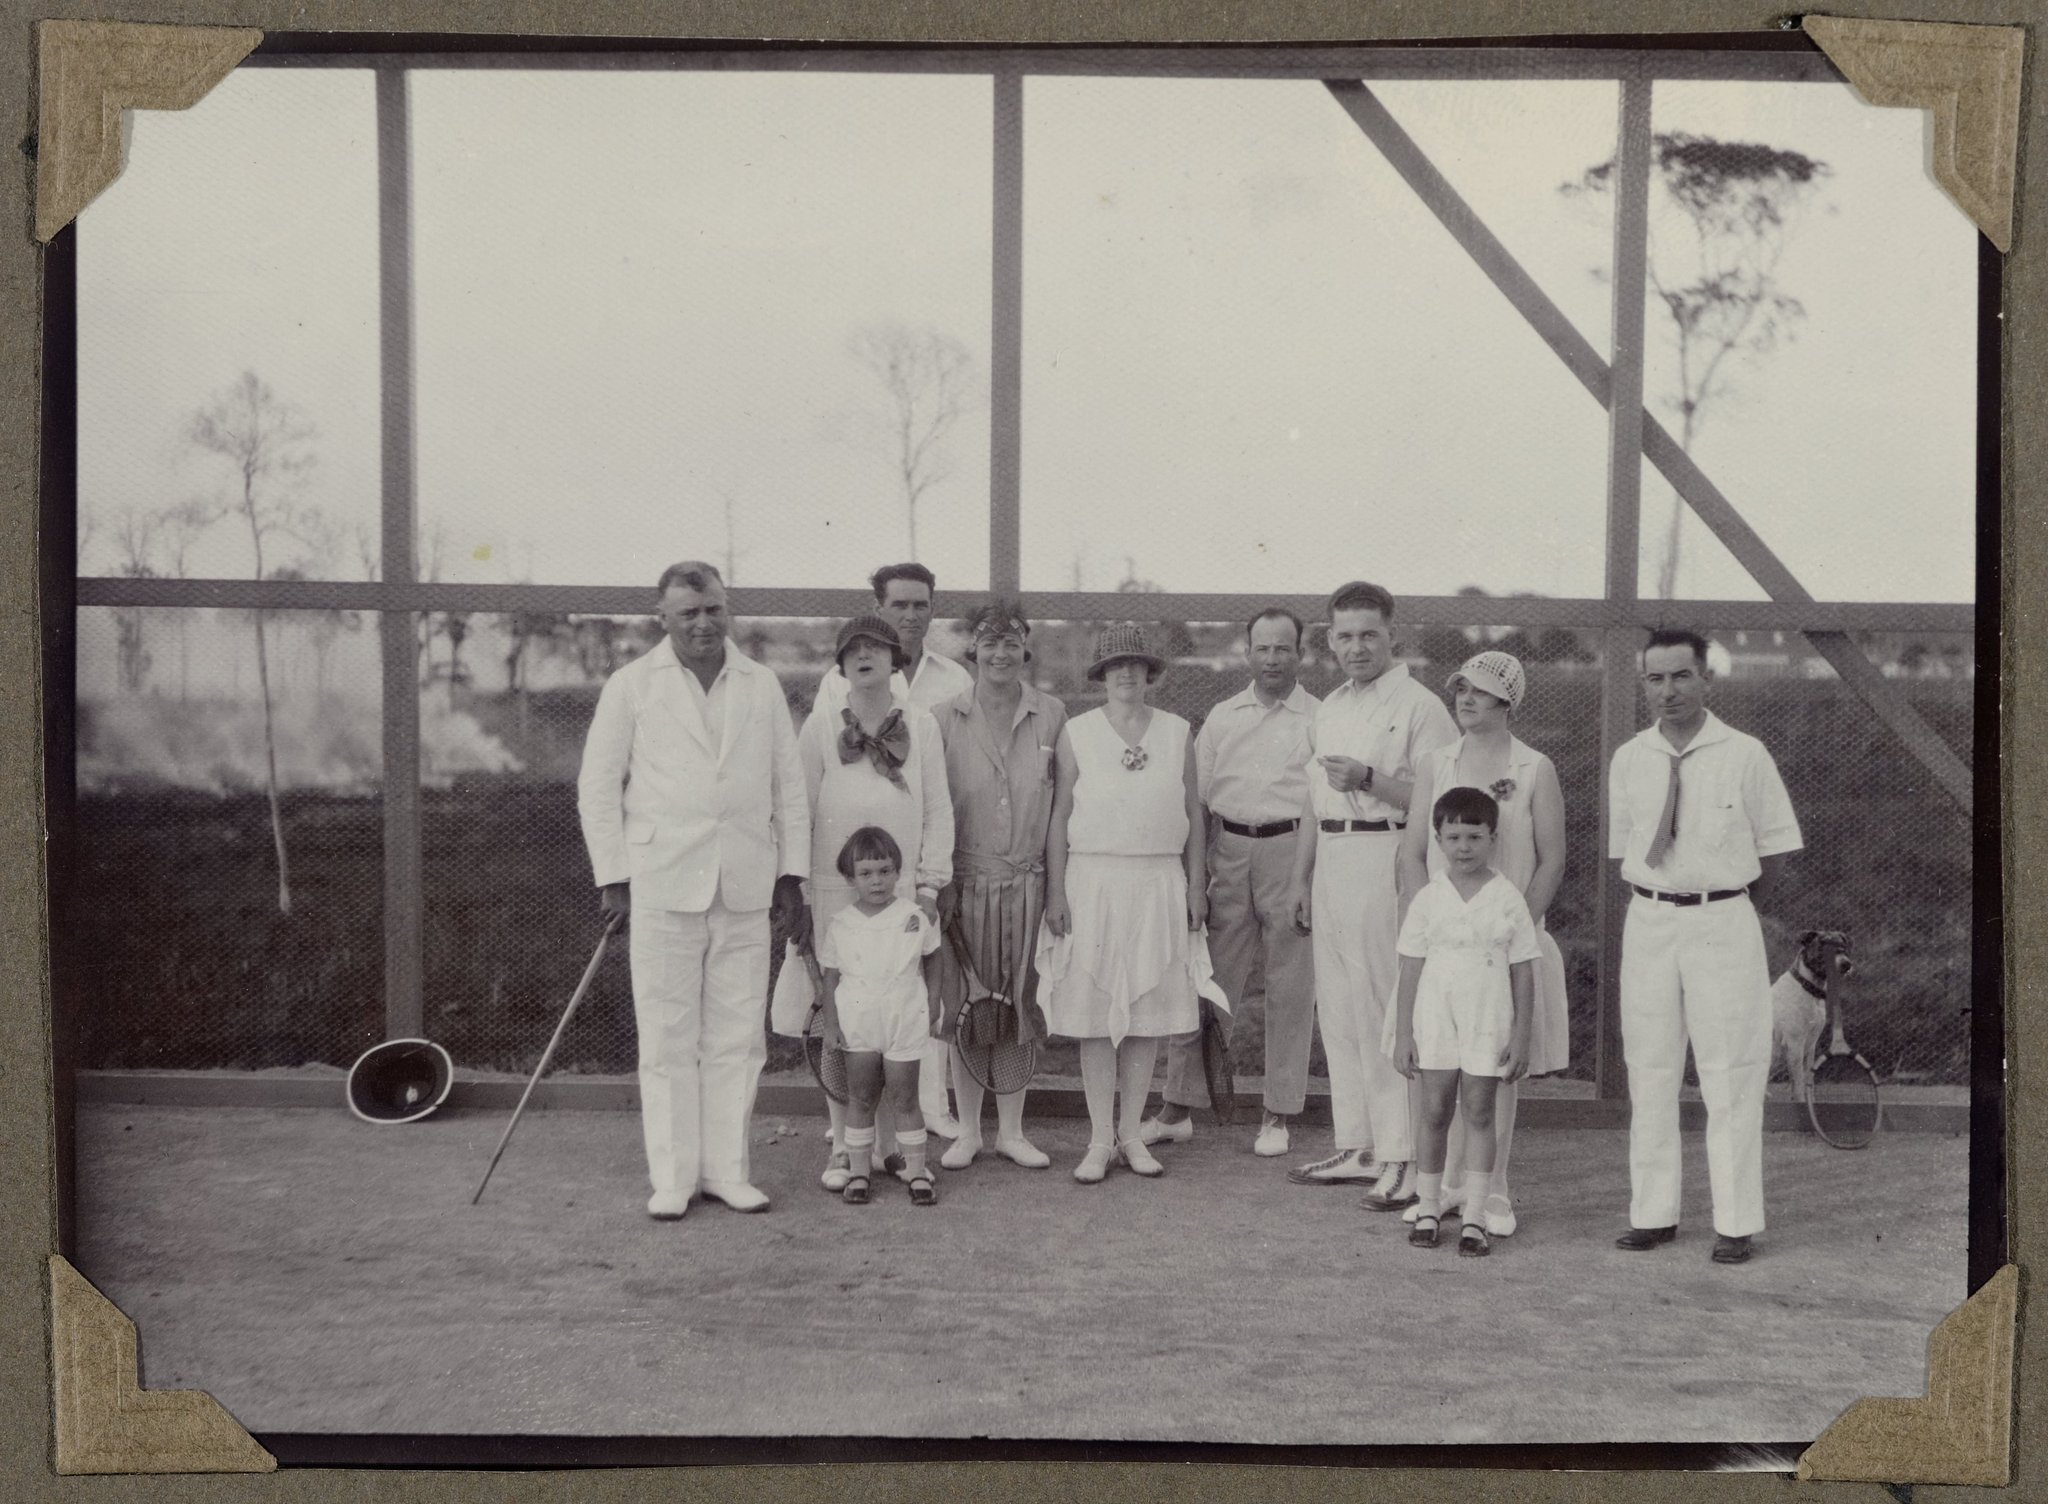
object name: photograph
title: Groepsfoto op de tennisclub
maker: Anonymous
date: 1925-1927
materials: photographic support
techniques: photography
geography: suriname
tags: tennis, lawn-tennis, anonymous historical persons portrayed in a group, in a group-portrait, suriname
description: Groepsfoto op de tennisclub. Foto met hoekjes bevestigd op een bladzijde van een albumblad in het fotoalbum over de familie Jetten en het leven en werken in de mijnstad Moengo in Suriname rond 1927.